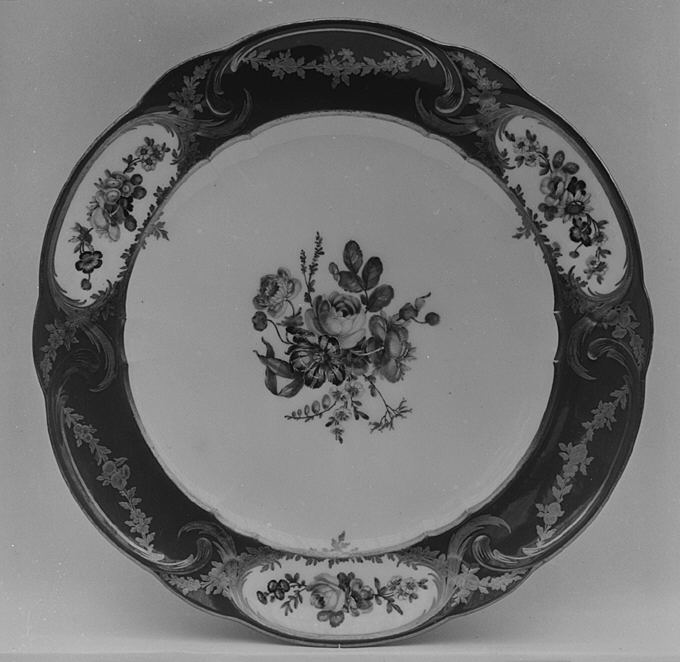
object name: plate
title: Plate (Assiette à palmes) (1 of 102) (part of a service)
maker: sèvres manufactory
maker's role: manufactory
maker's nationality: french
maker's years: 1740-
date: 1772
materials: soft paste porcelain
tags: flowers